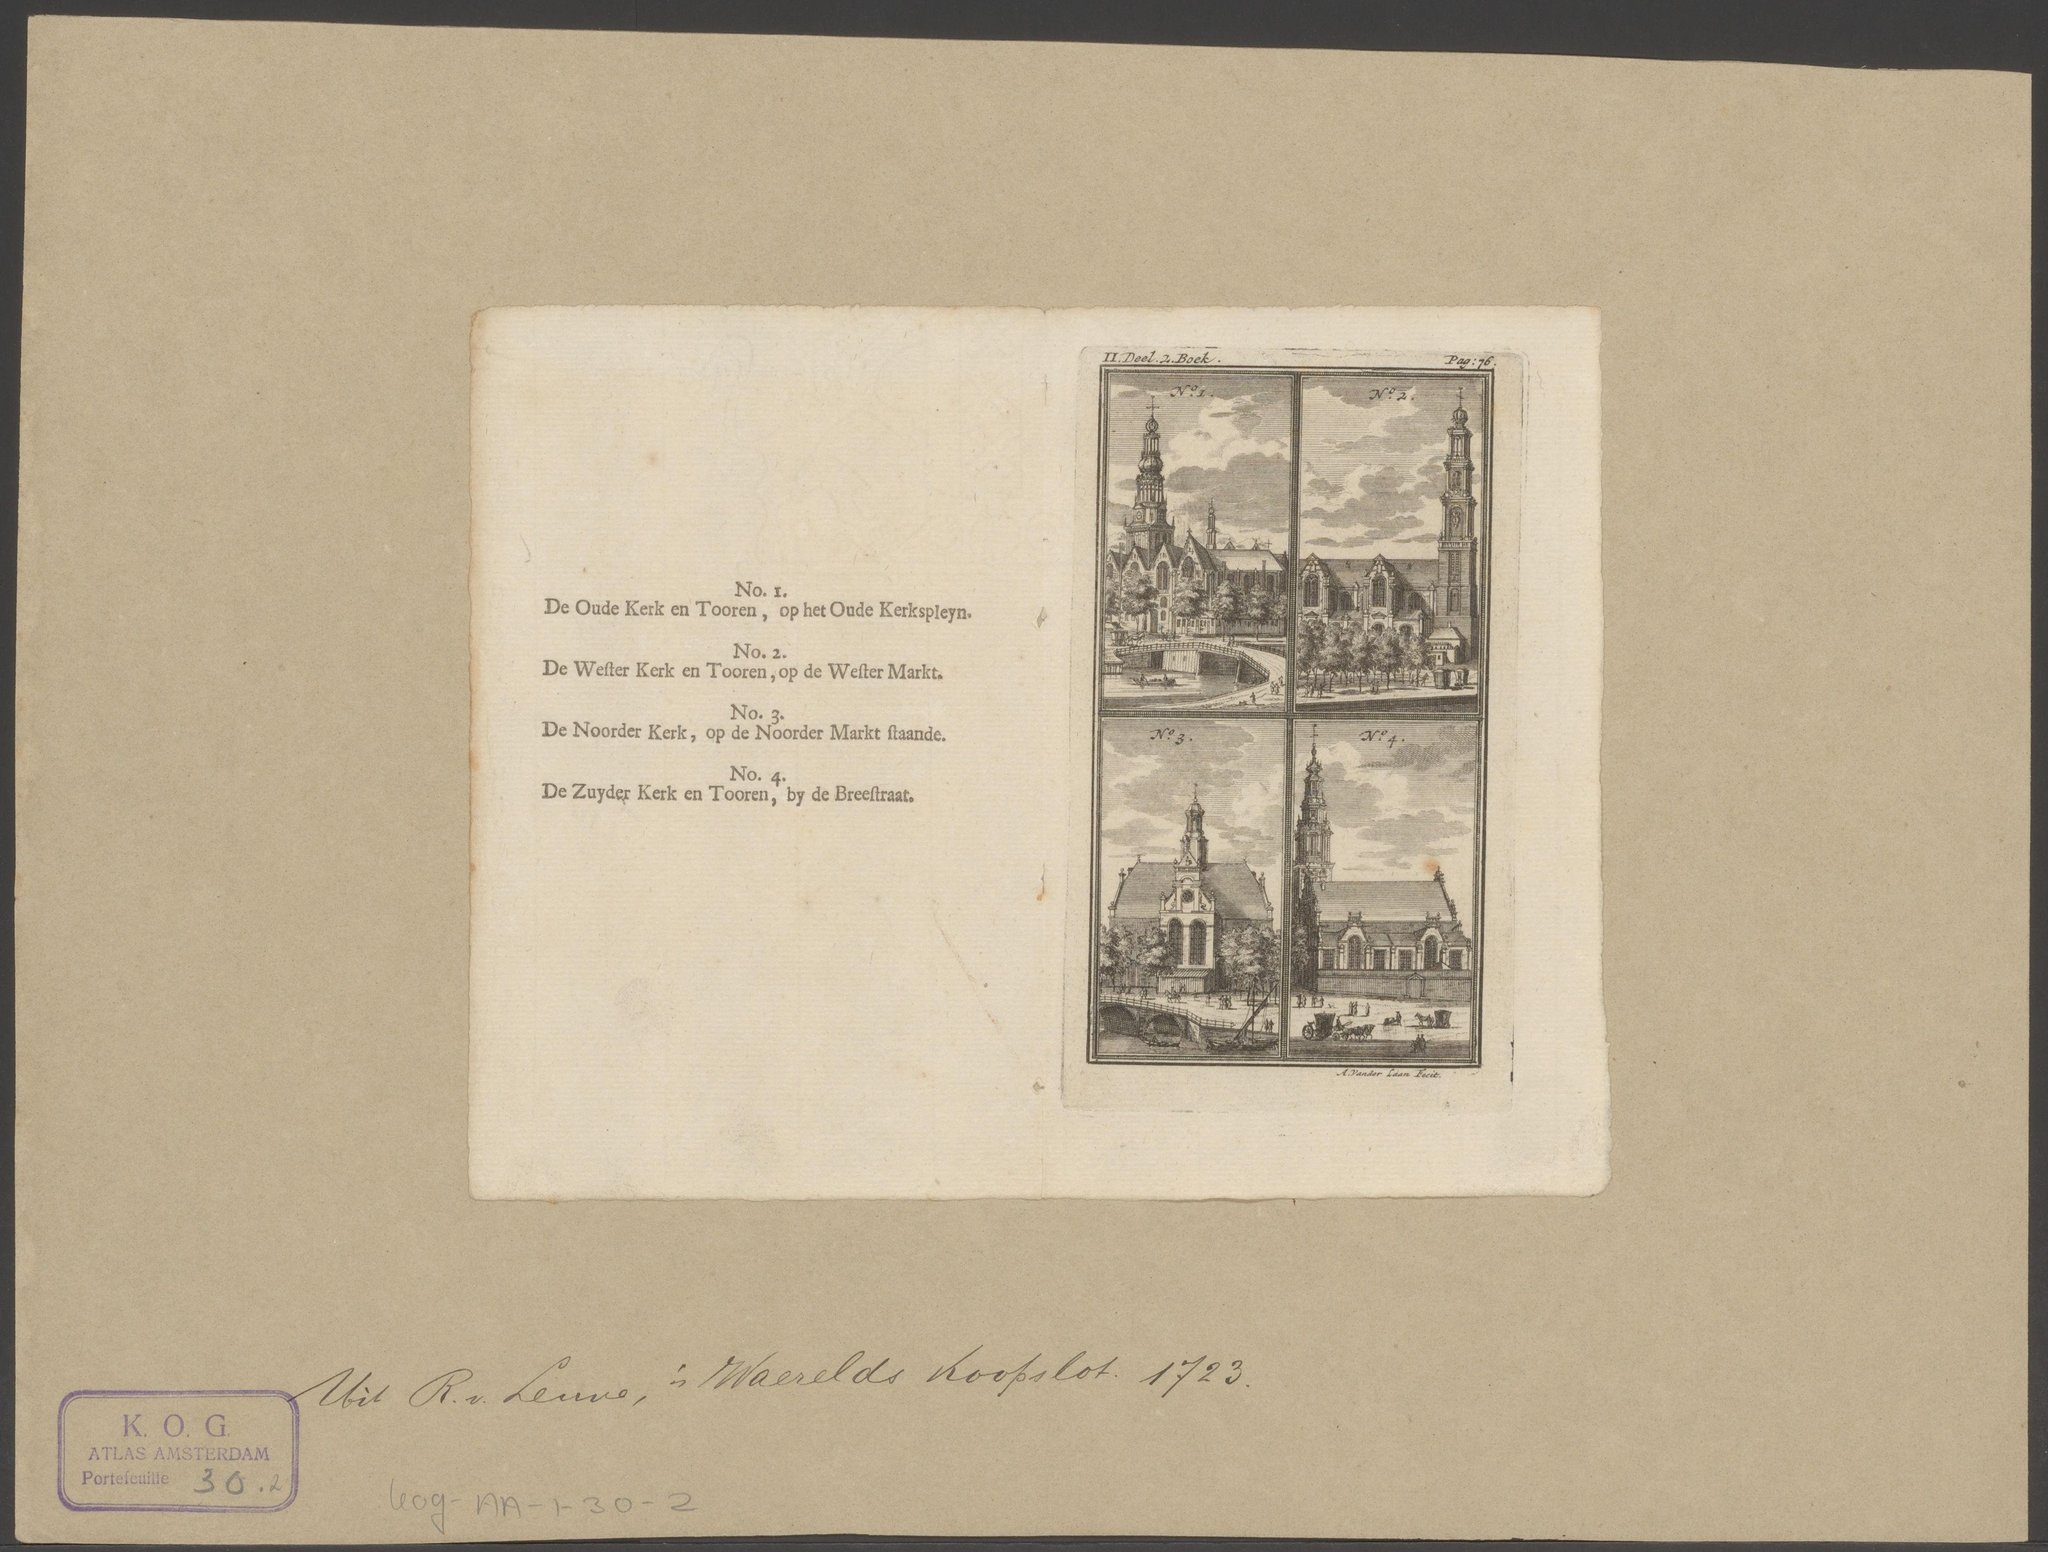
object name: print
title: Vier verschillende kerken te Amsterdam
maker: adolf van der laan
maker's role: draughtsman, print maker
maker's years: 1689-1742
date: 1723-1730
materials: paper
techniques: etching, letterpress printing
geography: northern netherlands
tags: church (exterior), city-view, and landscape with man-made constructions (+ city(-scape) with figures, staffage)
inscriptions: collector's mark: Lugt 1641b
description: Individuele voorstellingen van Oude Kerk, Westerkerk, Noorderkerk en Zuiderkerk, genummerd van No. 1 tot en met No. 4. Bovenaan gemerkt: II. Deel. 2. Boek. / Pag: 76. Onderwerpsrubriek binnen de Atlas Amsterdam: Kerkwezen: Verzamelbladen protestantse kerken.